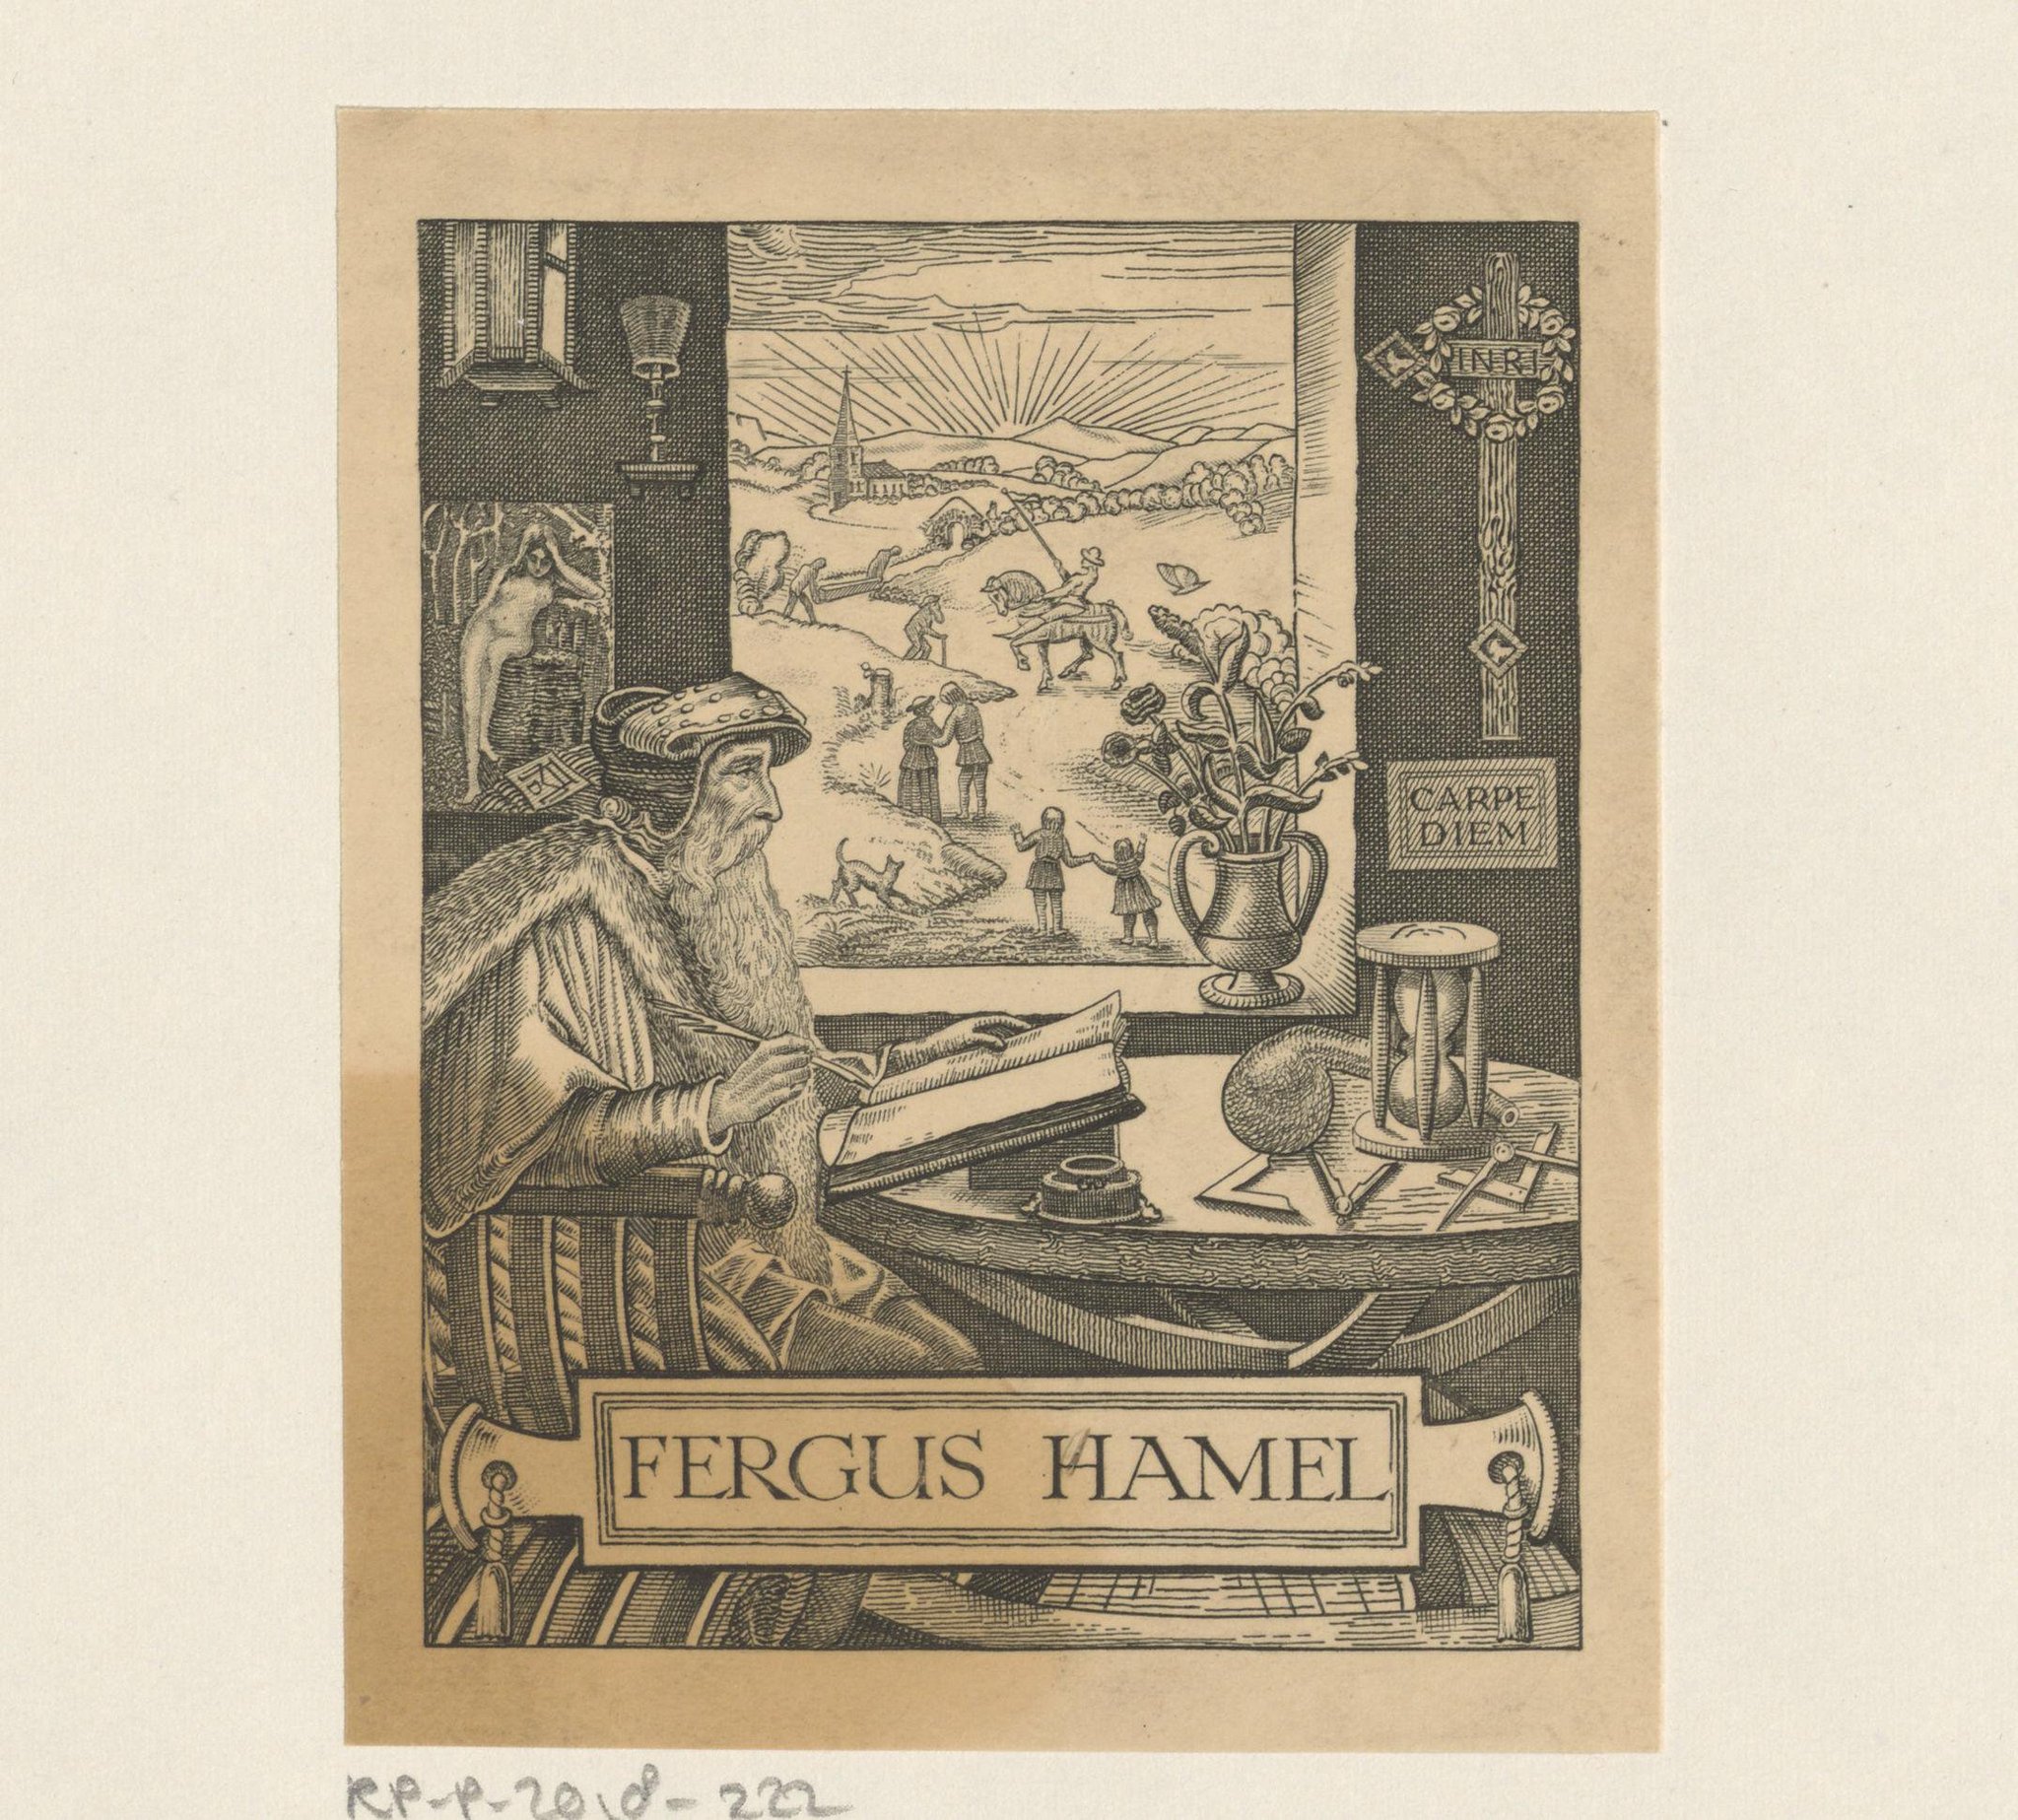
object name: bookplate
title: Ex libris van Fergus Hamel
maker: dorothy adams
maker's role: print maker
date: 1880-1949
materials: paper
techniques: engraving, etching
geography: england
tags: riding a horse, ass, or mule; rider, horseman, scholar in his study, sitting figure, view through a window, old man, historical costume, book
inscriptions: inscription: ‘He also gave me his own book-plate/ designed by same artist [...]/ signed DA = Dorothy Adams/ [...] Williams)/ of Maryleborne’